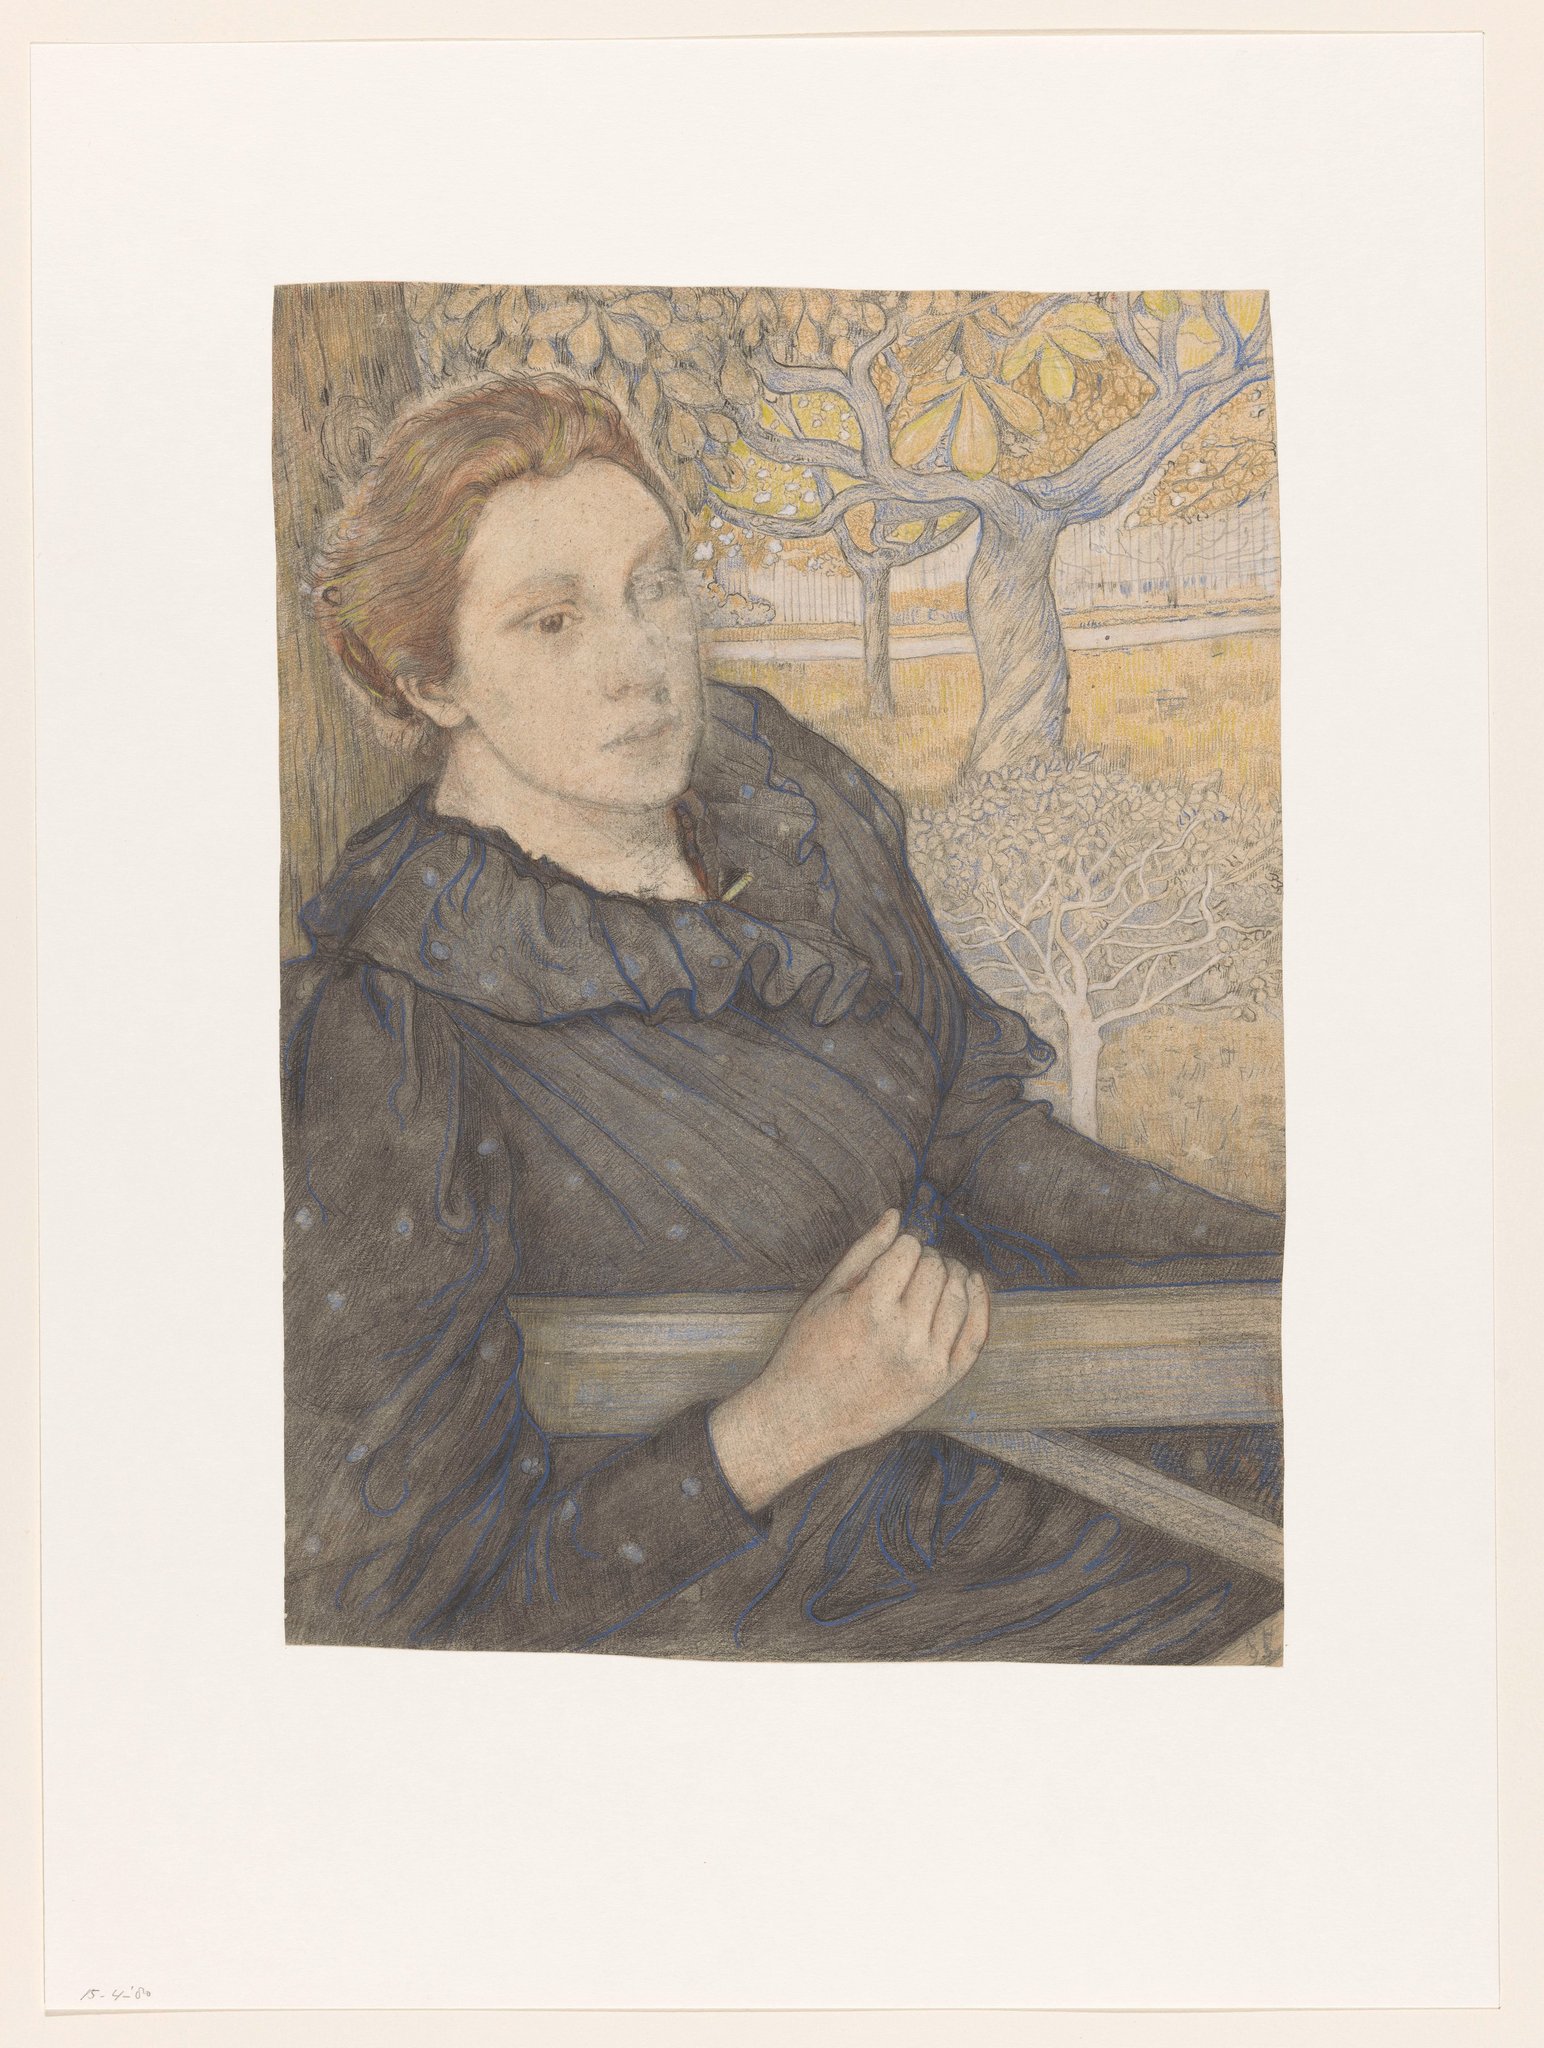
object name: drawing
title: Henriëtte van der Schalk in een tuin te Noordwijk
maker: richard nicolaüs roland holst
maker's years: 1868-1938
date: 1893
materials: chalk, paper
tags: amsterdam, henriëtte roland holst-van der schalk, historical persons